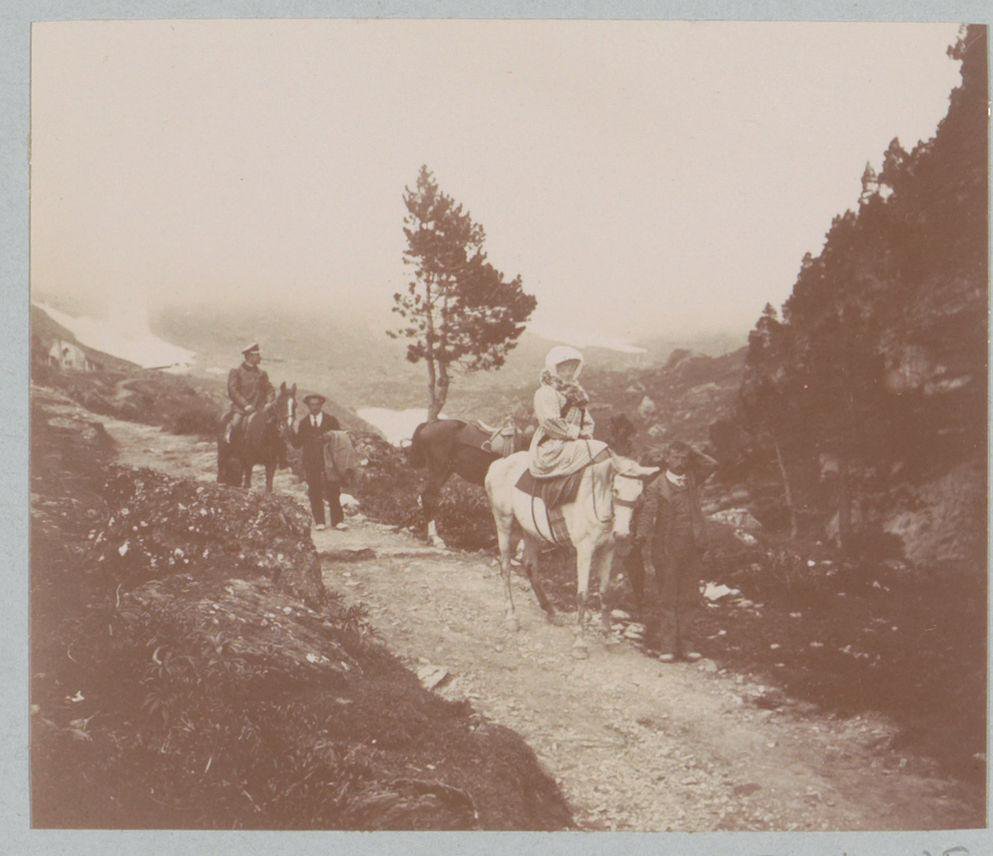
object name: photograph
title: Man en vrouw te paard en twee begeleiders op een pad, vermoedelijk in de Pyreneeën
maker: Anonymous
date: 1905-1910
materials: paper, photographic support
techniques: gelatin silver print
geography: pyrenees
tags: riding a horse, ass, or mule; rider, horseman, road, path, mountains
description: Onderdeel van Fotoalbum van een Franse amateurfotograaf met bezienswaardigheden in Frankrijk, Zwitserland en Italië.